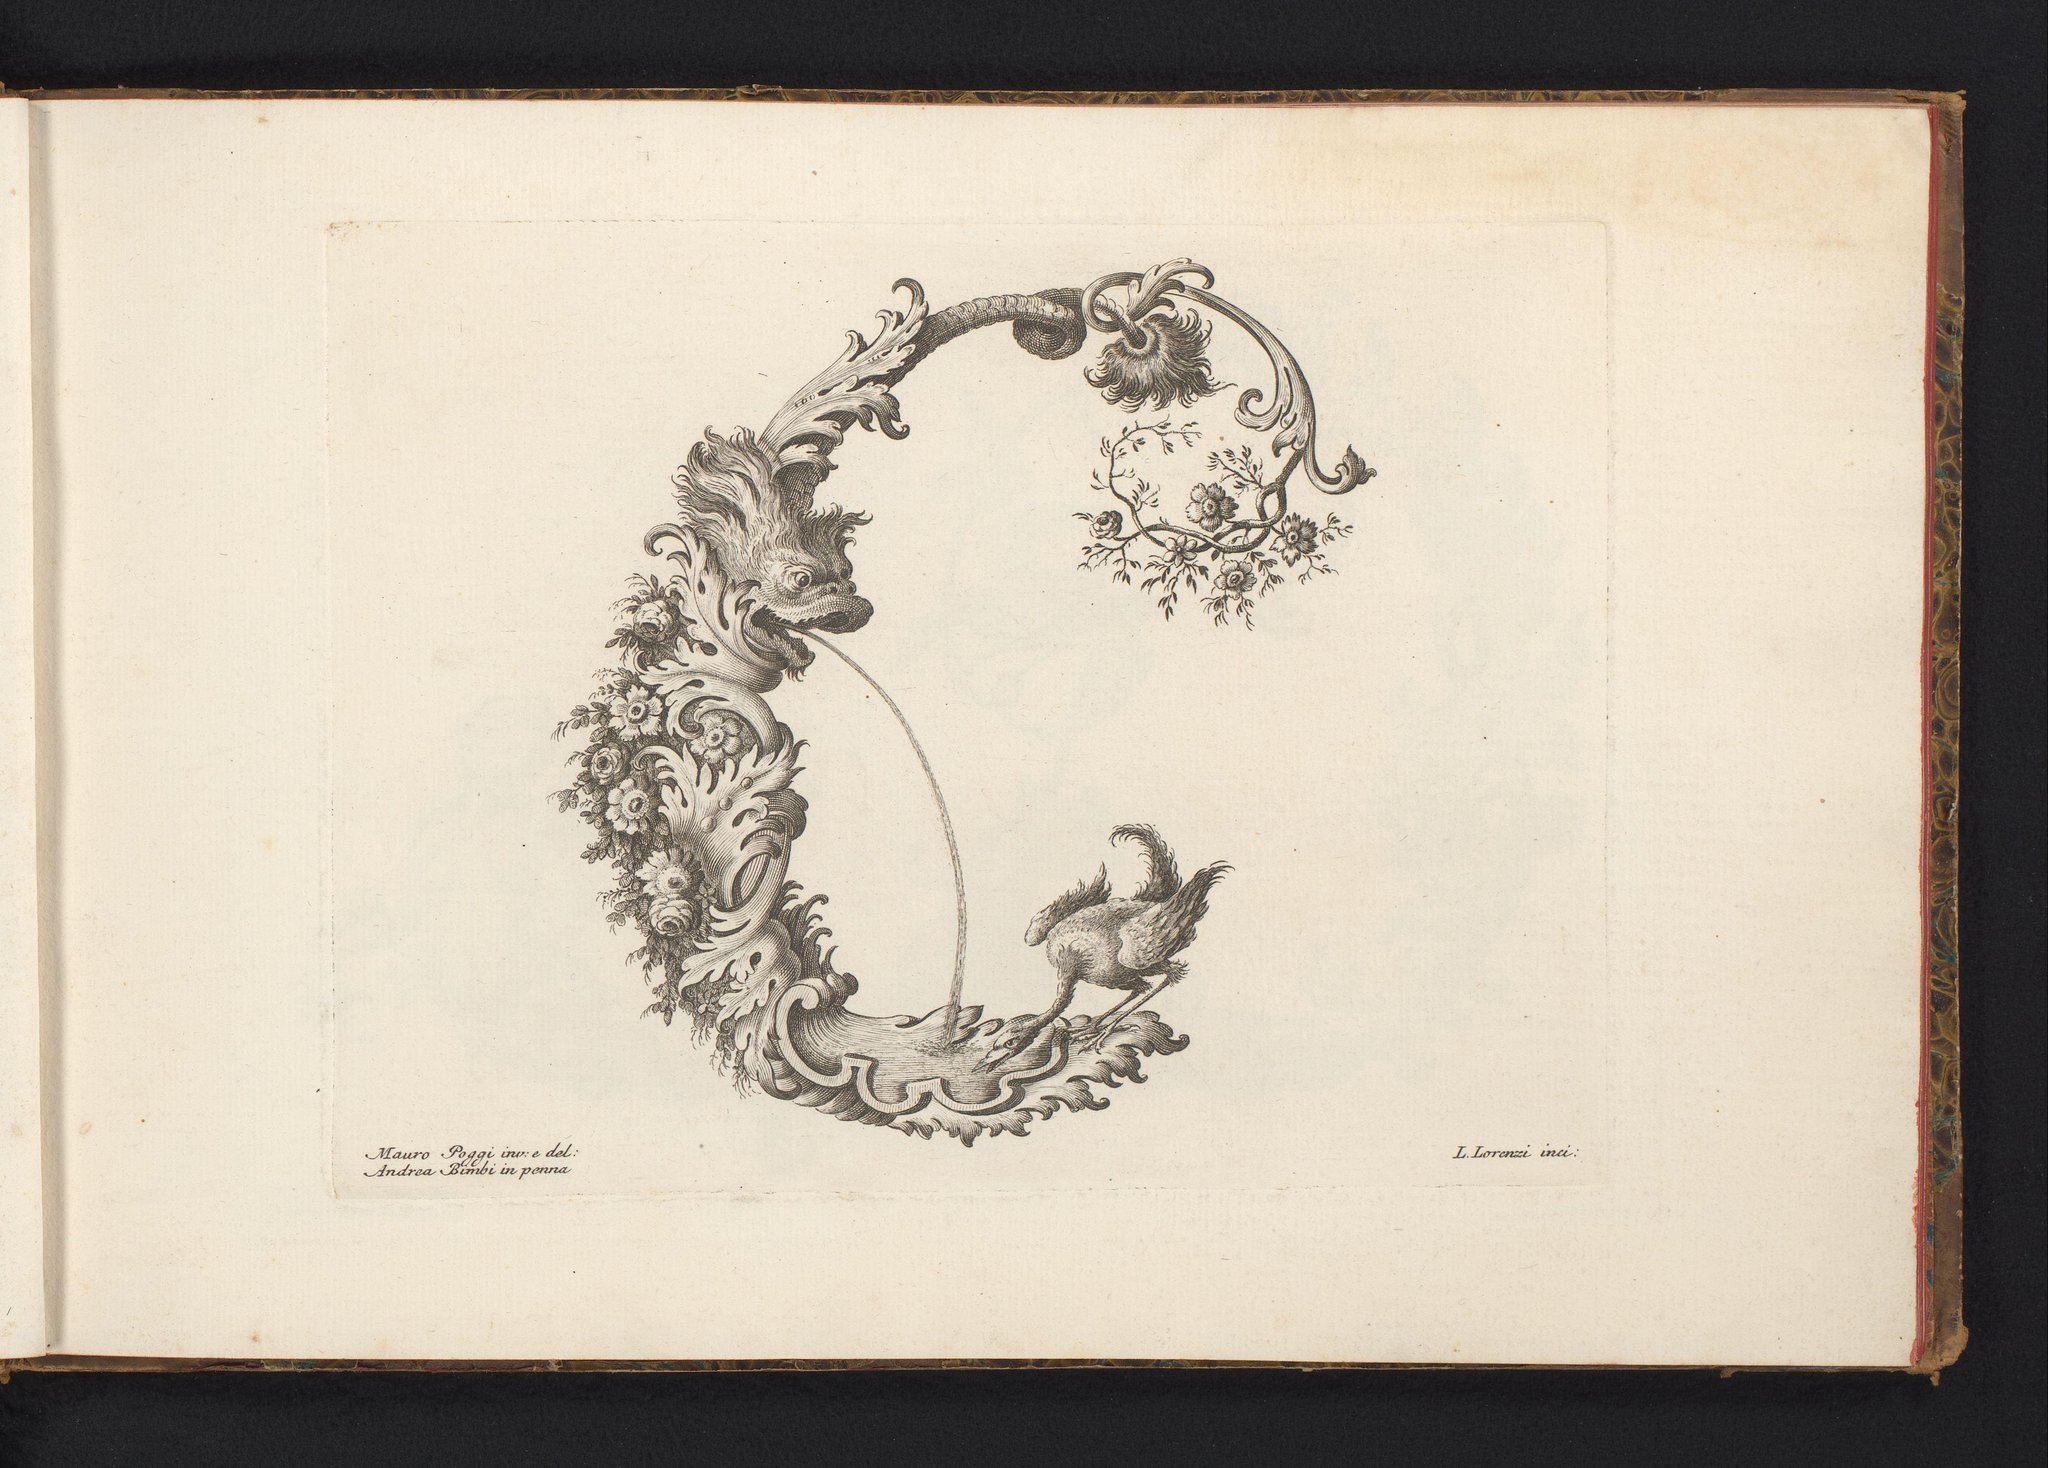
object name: album leaf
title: Ornamentele letter C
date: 1745-1765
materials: paper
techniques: engraving, etching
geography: italy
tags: letters, alphabet, script, fancy letters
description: Ornamentele letter C, versierd met bloemen en een drinkende vogel. Prent maakt deel uit van een album.